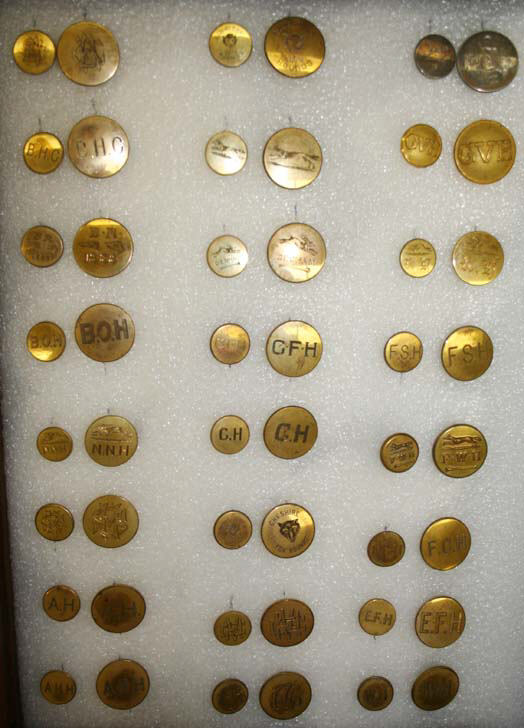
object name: button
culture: british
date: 1850-1880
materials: metal